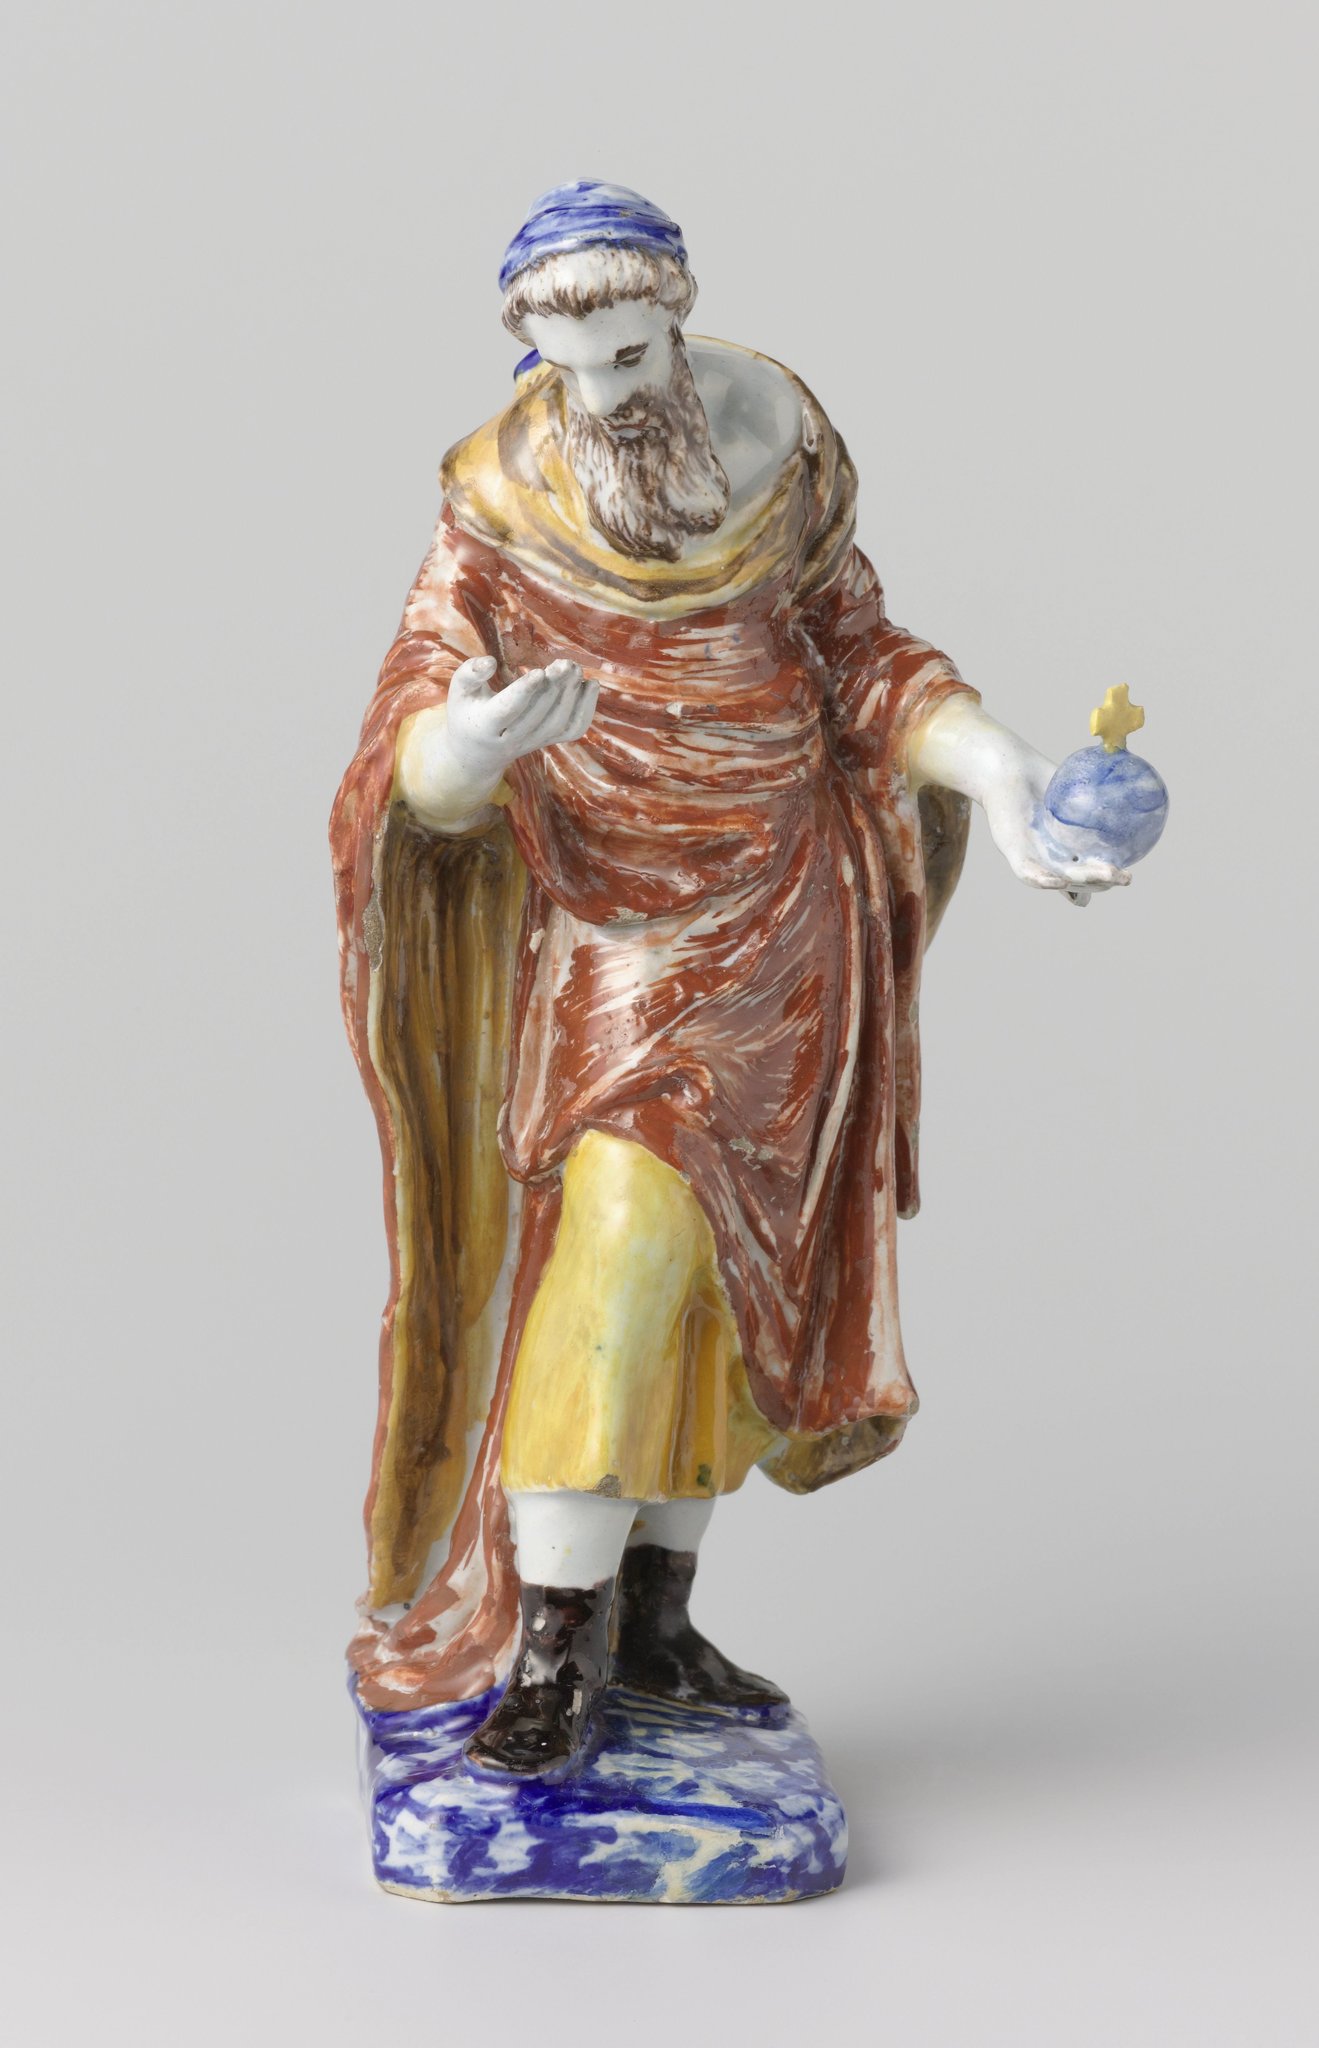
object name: decoratief object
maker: Anonymous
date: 1760-1785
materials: faience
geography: delft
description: Mannenfiguur van faience, voorstellende Christus met de rijksappel in de hand. Veelkleurig beschilderd.